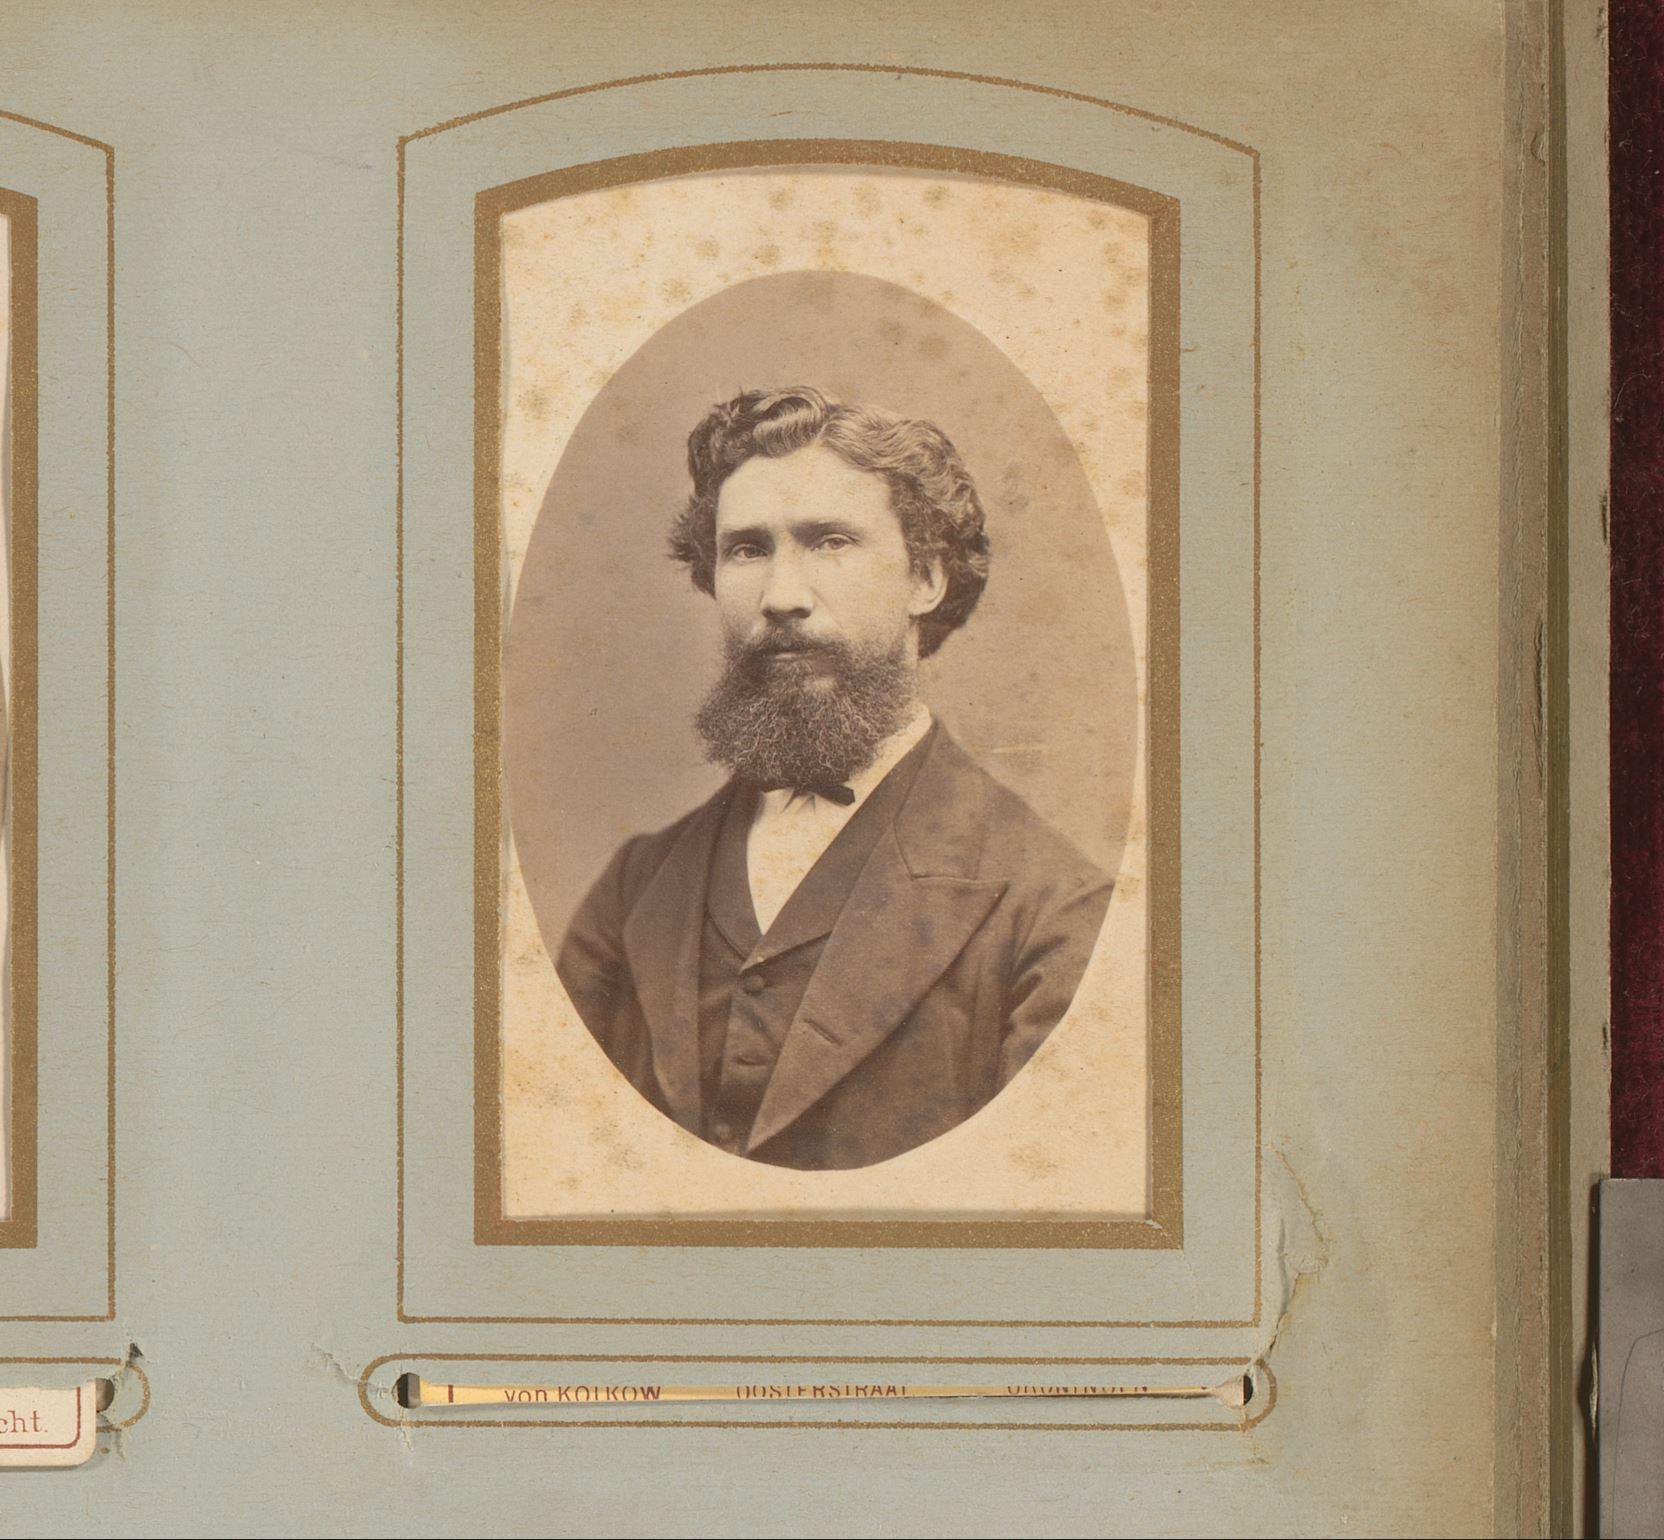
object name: photograph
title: Portret van een man met baard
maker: friedrich julius von kolkow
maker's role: fotograaf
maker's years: 1839-1914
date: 1880-1900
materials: cardboard, photographic support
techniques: albumen print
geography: the hague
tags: historical persons, beard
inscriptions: inscription: ‘Von Kolwow's/ nieuw/ Photographisch Atelier/ Groningen/ Oosterstraat/ Letter E. No 204’